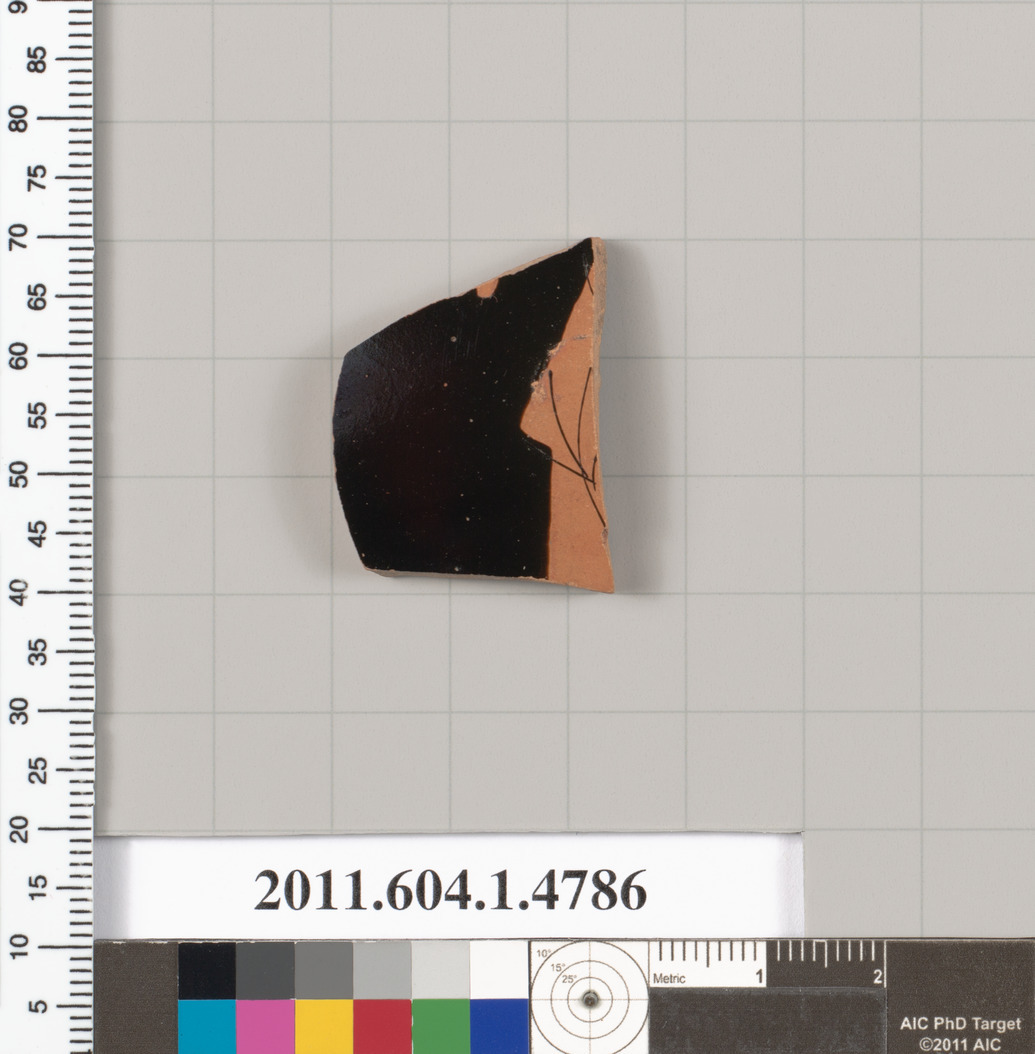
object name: kylix fragment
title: Terracotta fragment of a kylix (drinking cup)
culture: greek, attic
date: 475-451 BCE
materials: terracotta